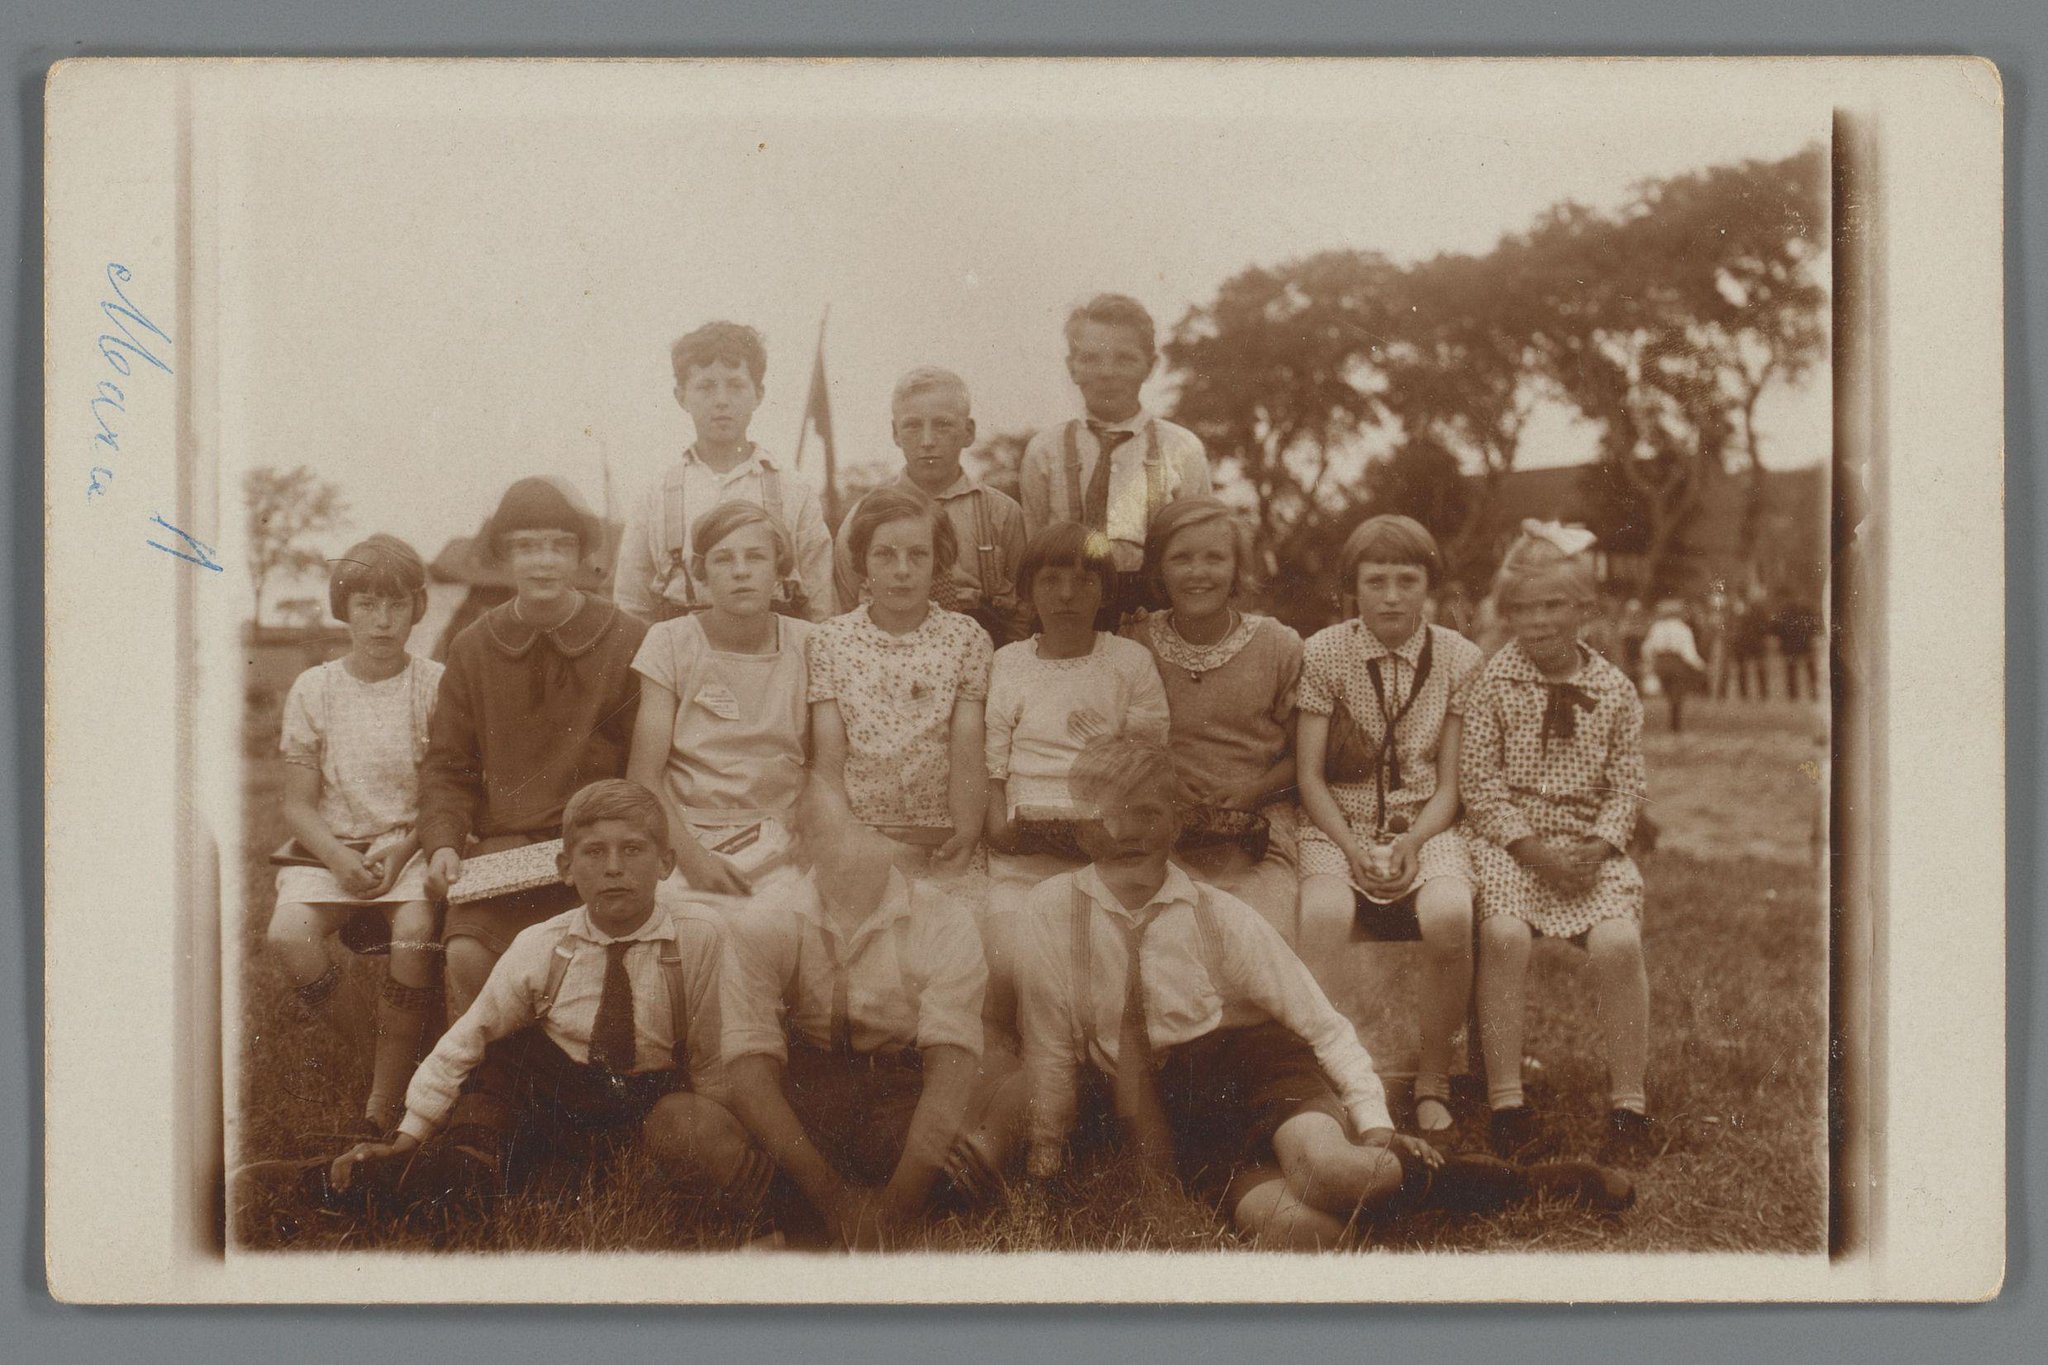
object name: ansichtkaart, prentbriefkaart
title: Groepsportret van een groep onbekende kinderen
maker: Anonymous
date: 1910-1933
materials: paper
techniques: collodion silver print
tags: child, anonymous historical persons portrayed in a group, in a group-portrait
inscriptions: inscription: ‘Cuart[?] weert’, inscription: ‘Maria’